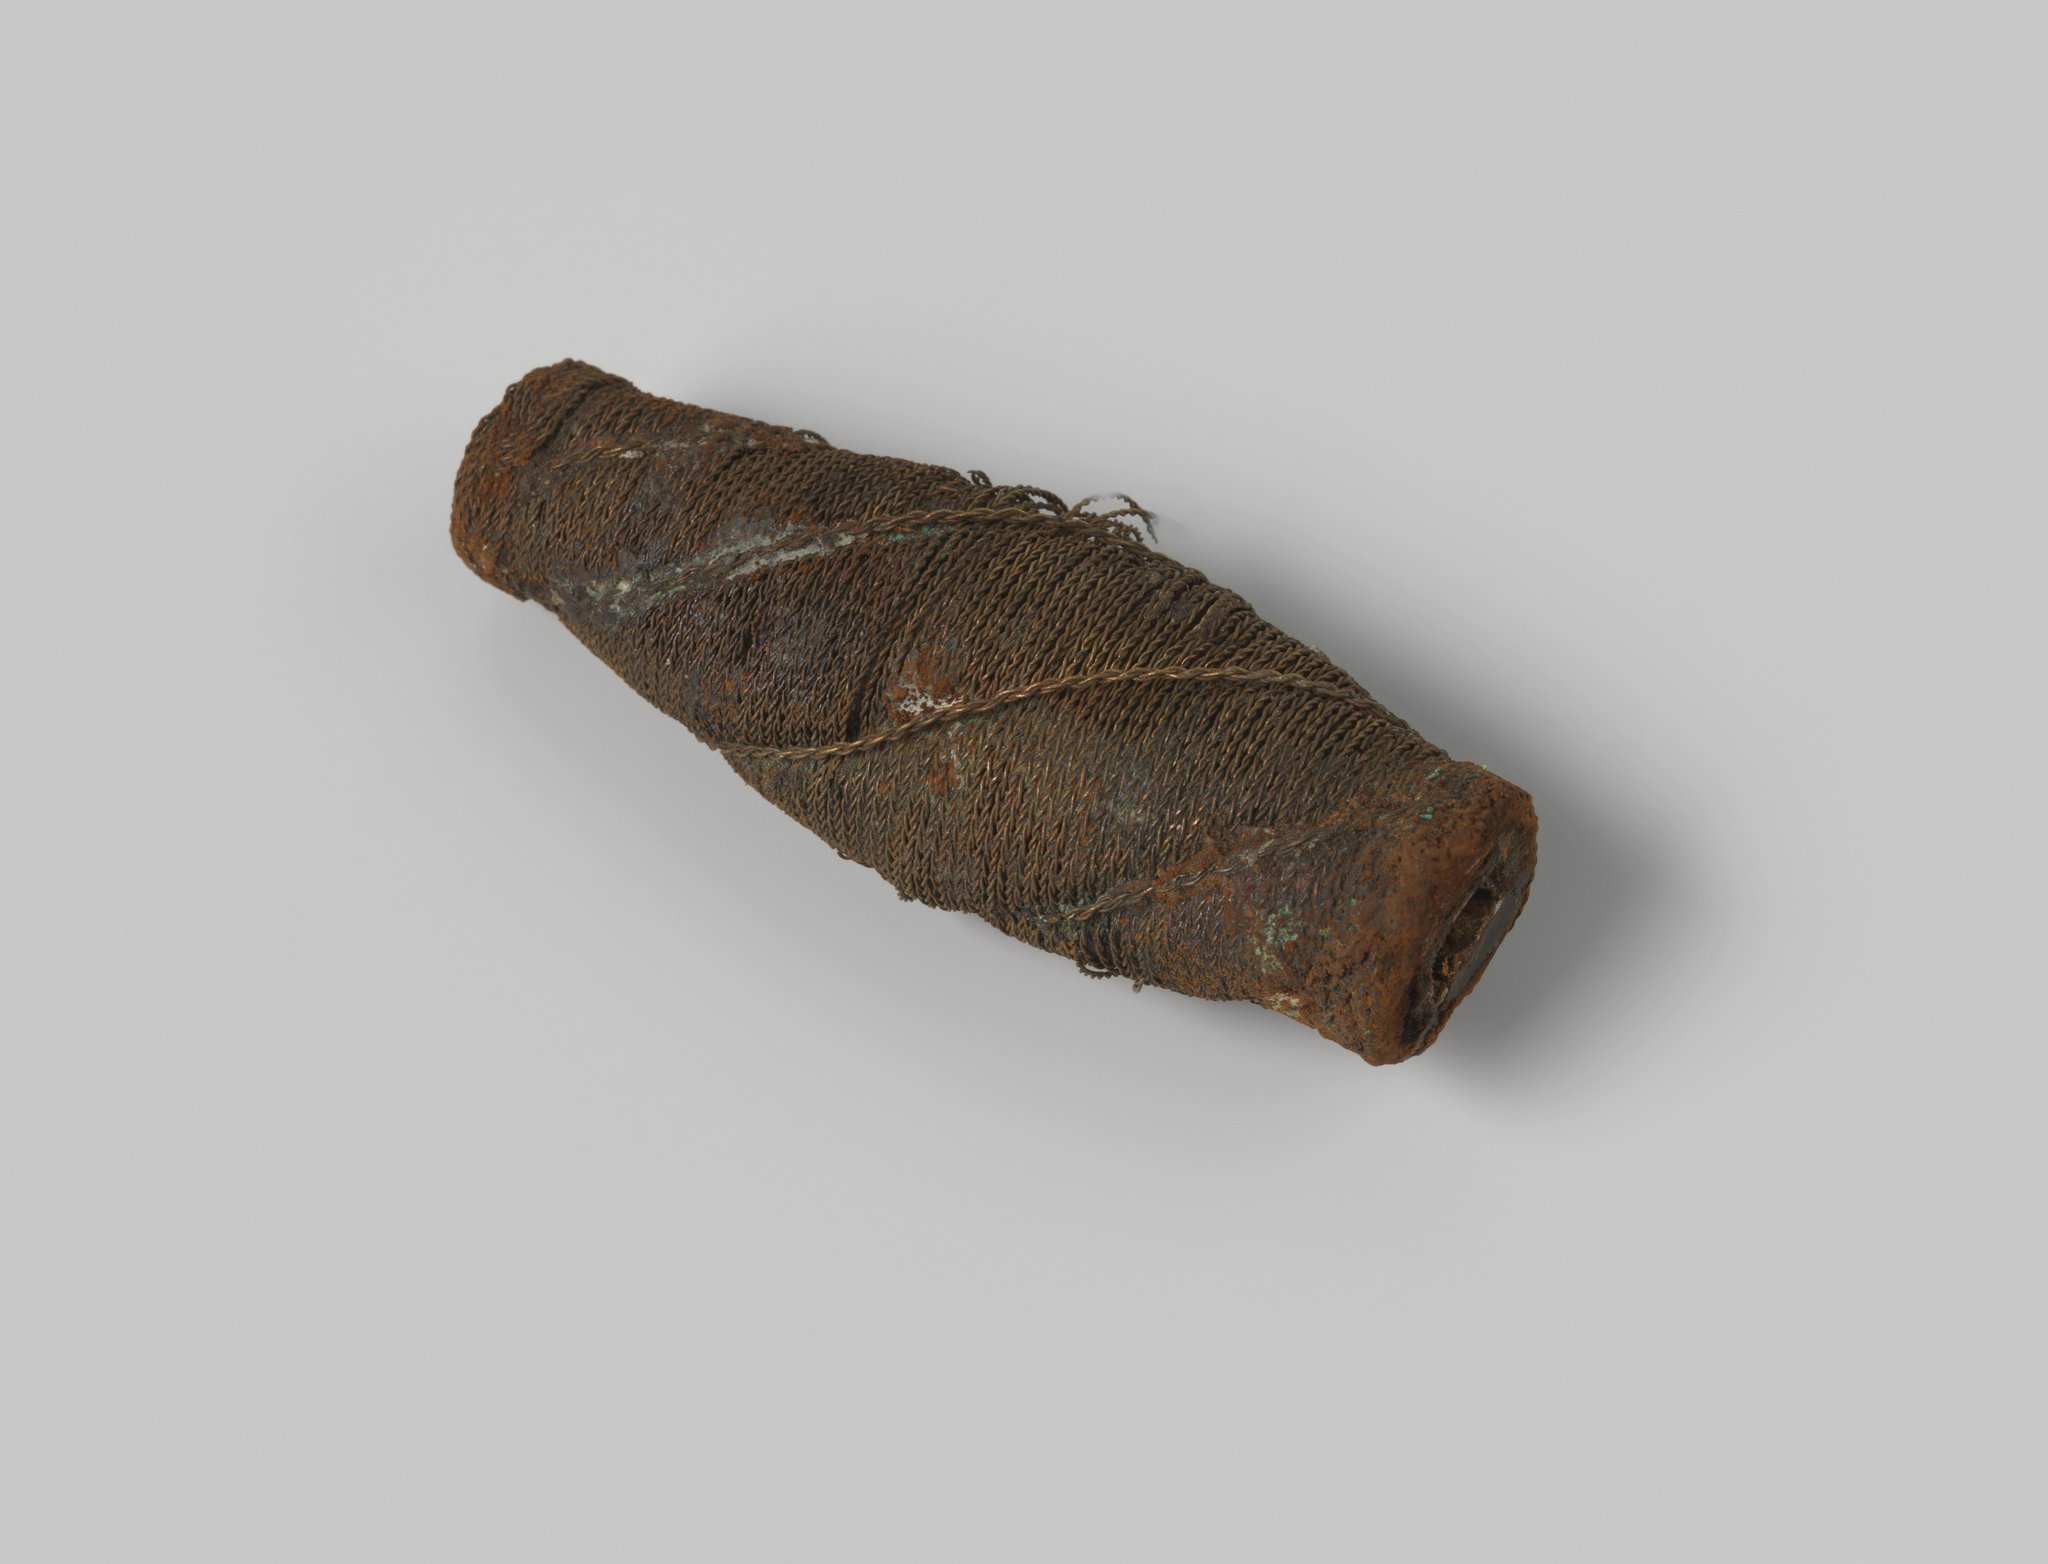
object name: greep gevest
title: Greep van een gevest uit het wrak van de Oost-Indiëvaarder Hollandia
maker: Anonymous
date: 1700-1743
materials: copper, wood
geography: netherlands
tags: verenigde oostindische compagnie, hollandia (schip), annet